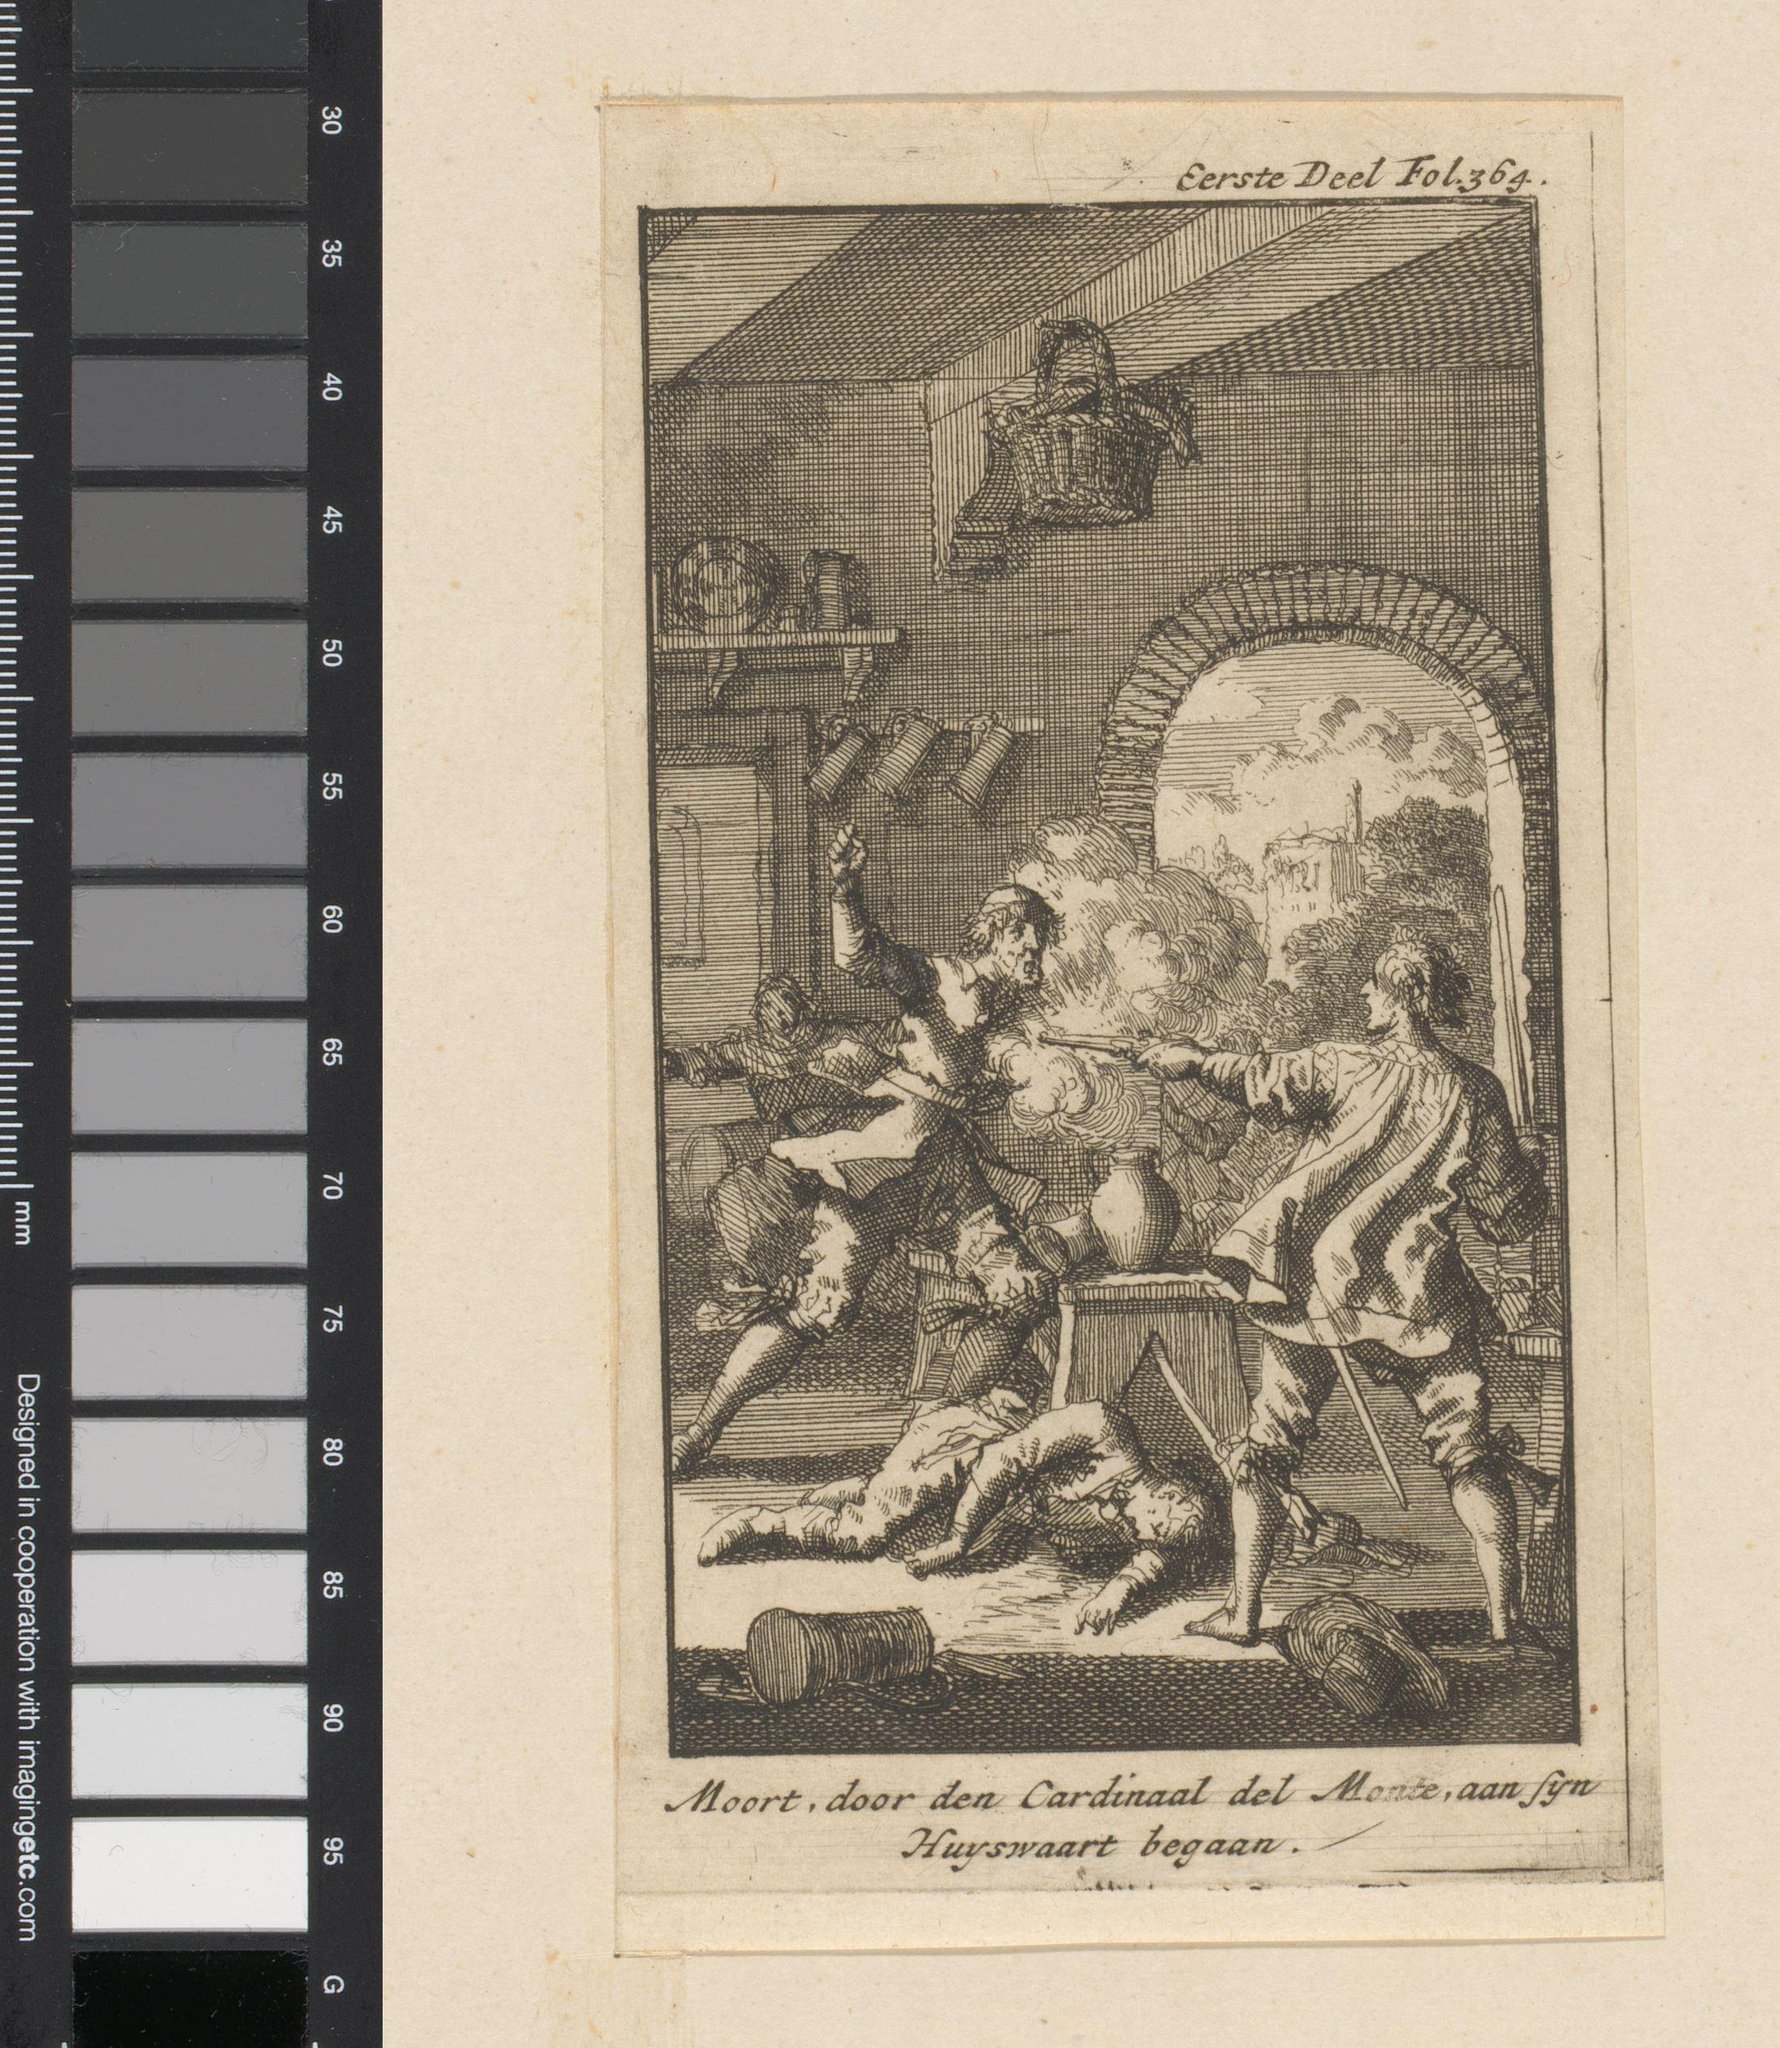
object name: print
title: Moort door de Cardinaal del Monte aan syn Huyswaart begaan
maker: jan luyken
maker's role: draughtsman, print maker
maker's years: 1649-1712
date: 1659-1712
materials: paper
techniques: etching